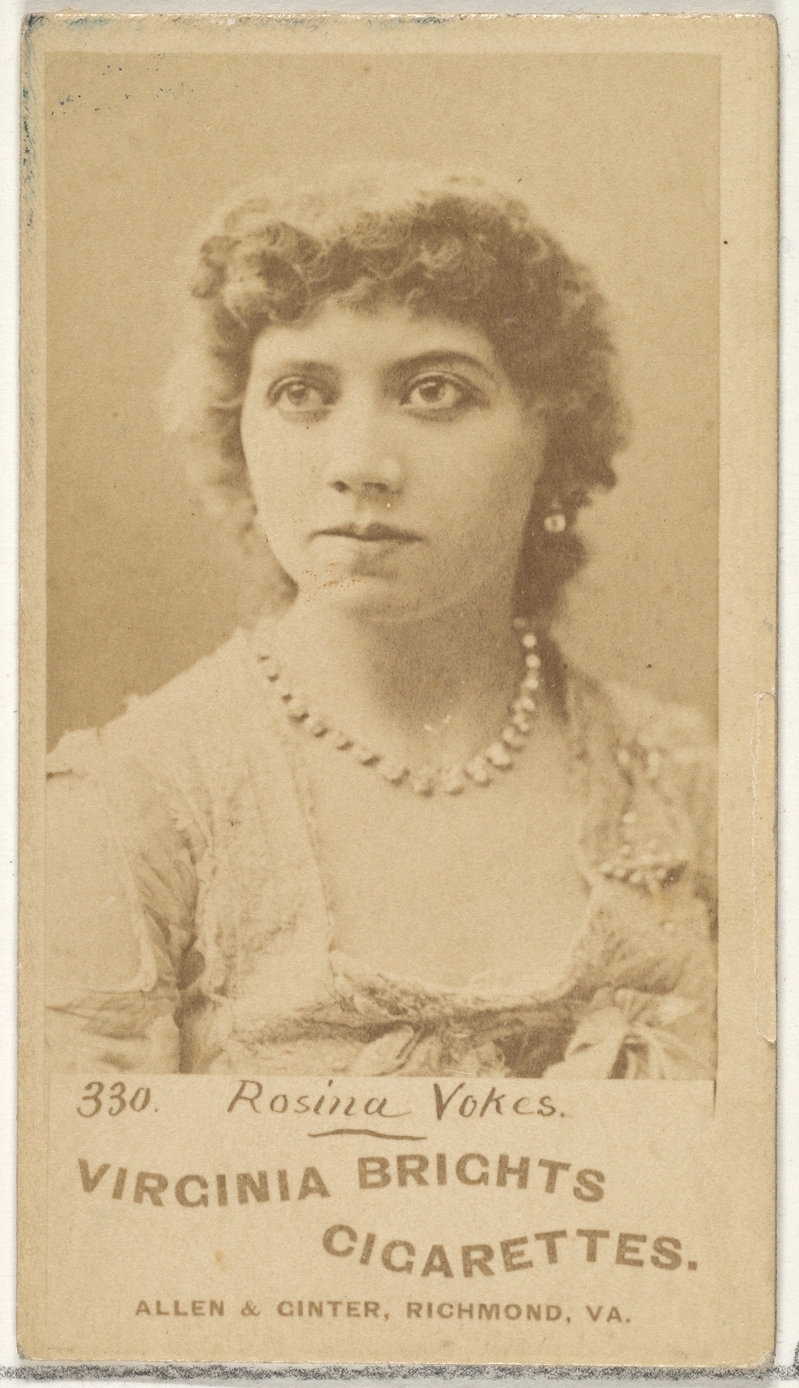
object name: photograph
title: Card 330, Rosina Vokes, from the Actors and Actresses series (N45, Type 1) for Virginia Brights Cigarettes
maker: allen & ginter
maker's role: publisher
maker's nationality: american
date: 1888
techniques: albumen silver print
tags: portraits,women,actresses